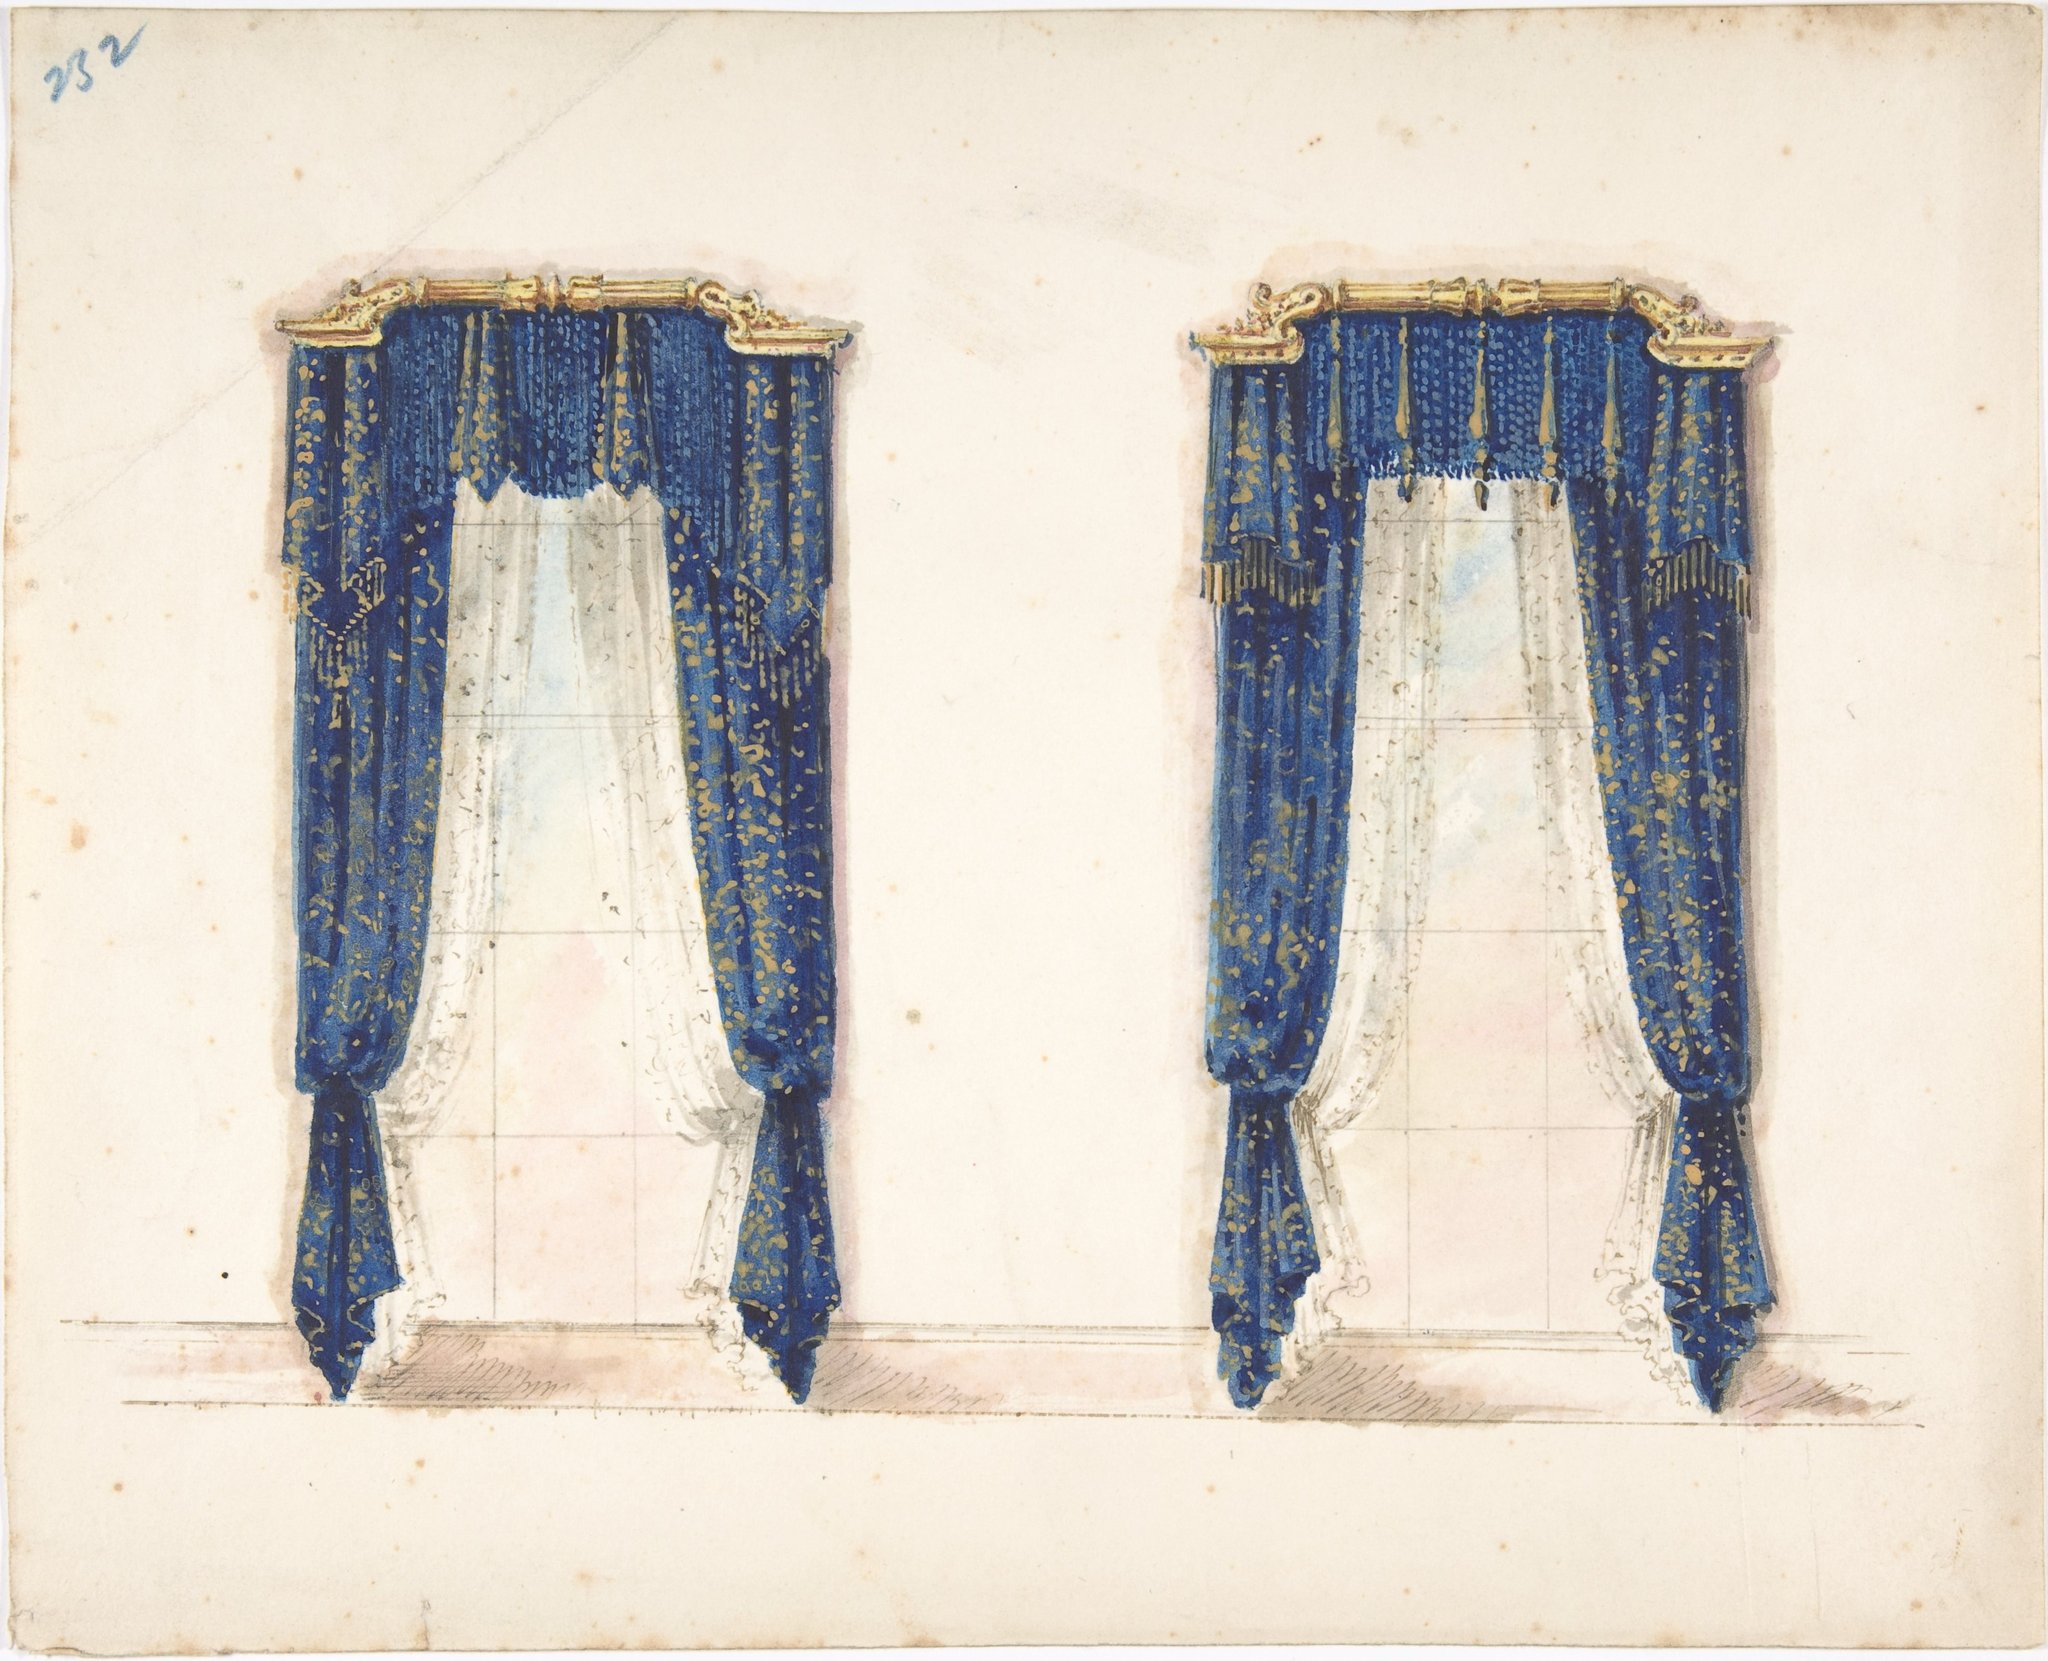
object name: drawing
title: Design for Blue and Gold Curtains with Gold Fringes and a Gold Pediment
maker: anonymous, british, 19th century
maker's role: artist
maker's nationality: british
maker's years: 1800-1900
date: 1801-1833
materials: ink, watercolor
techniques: brush, pen, wash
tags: curtains